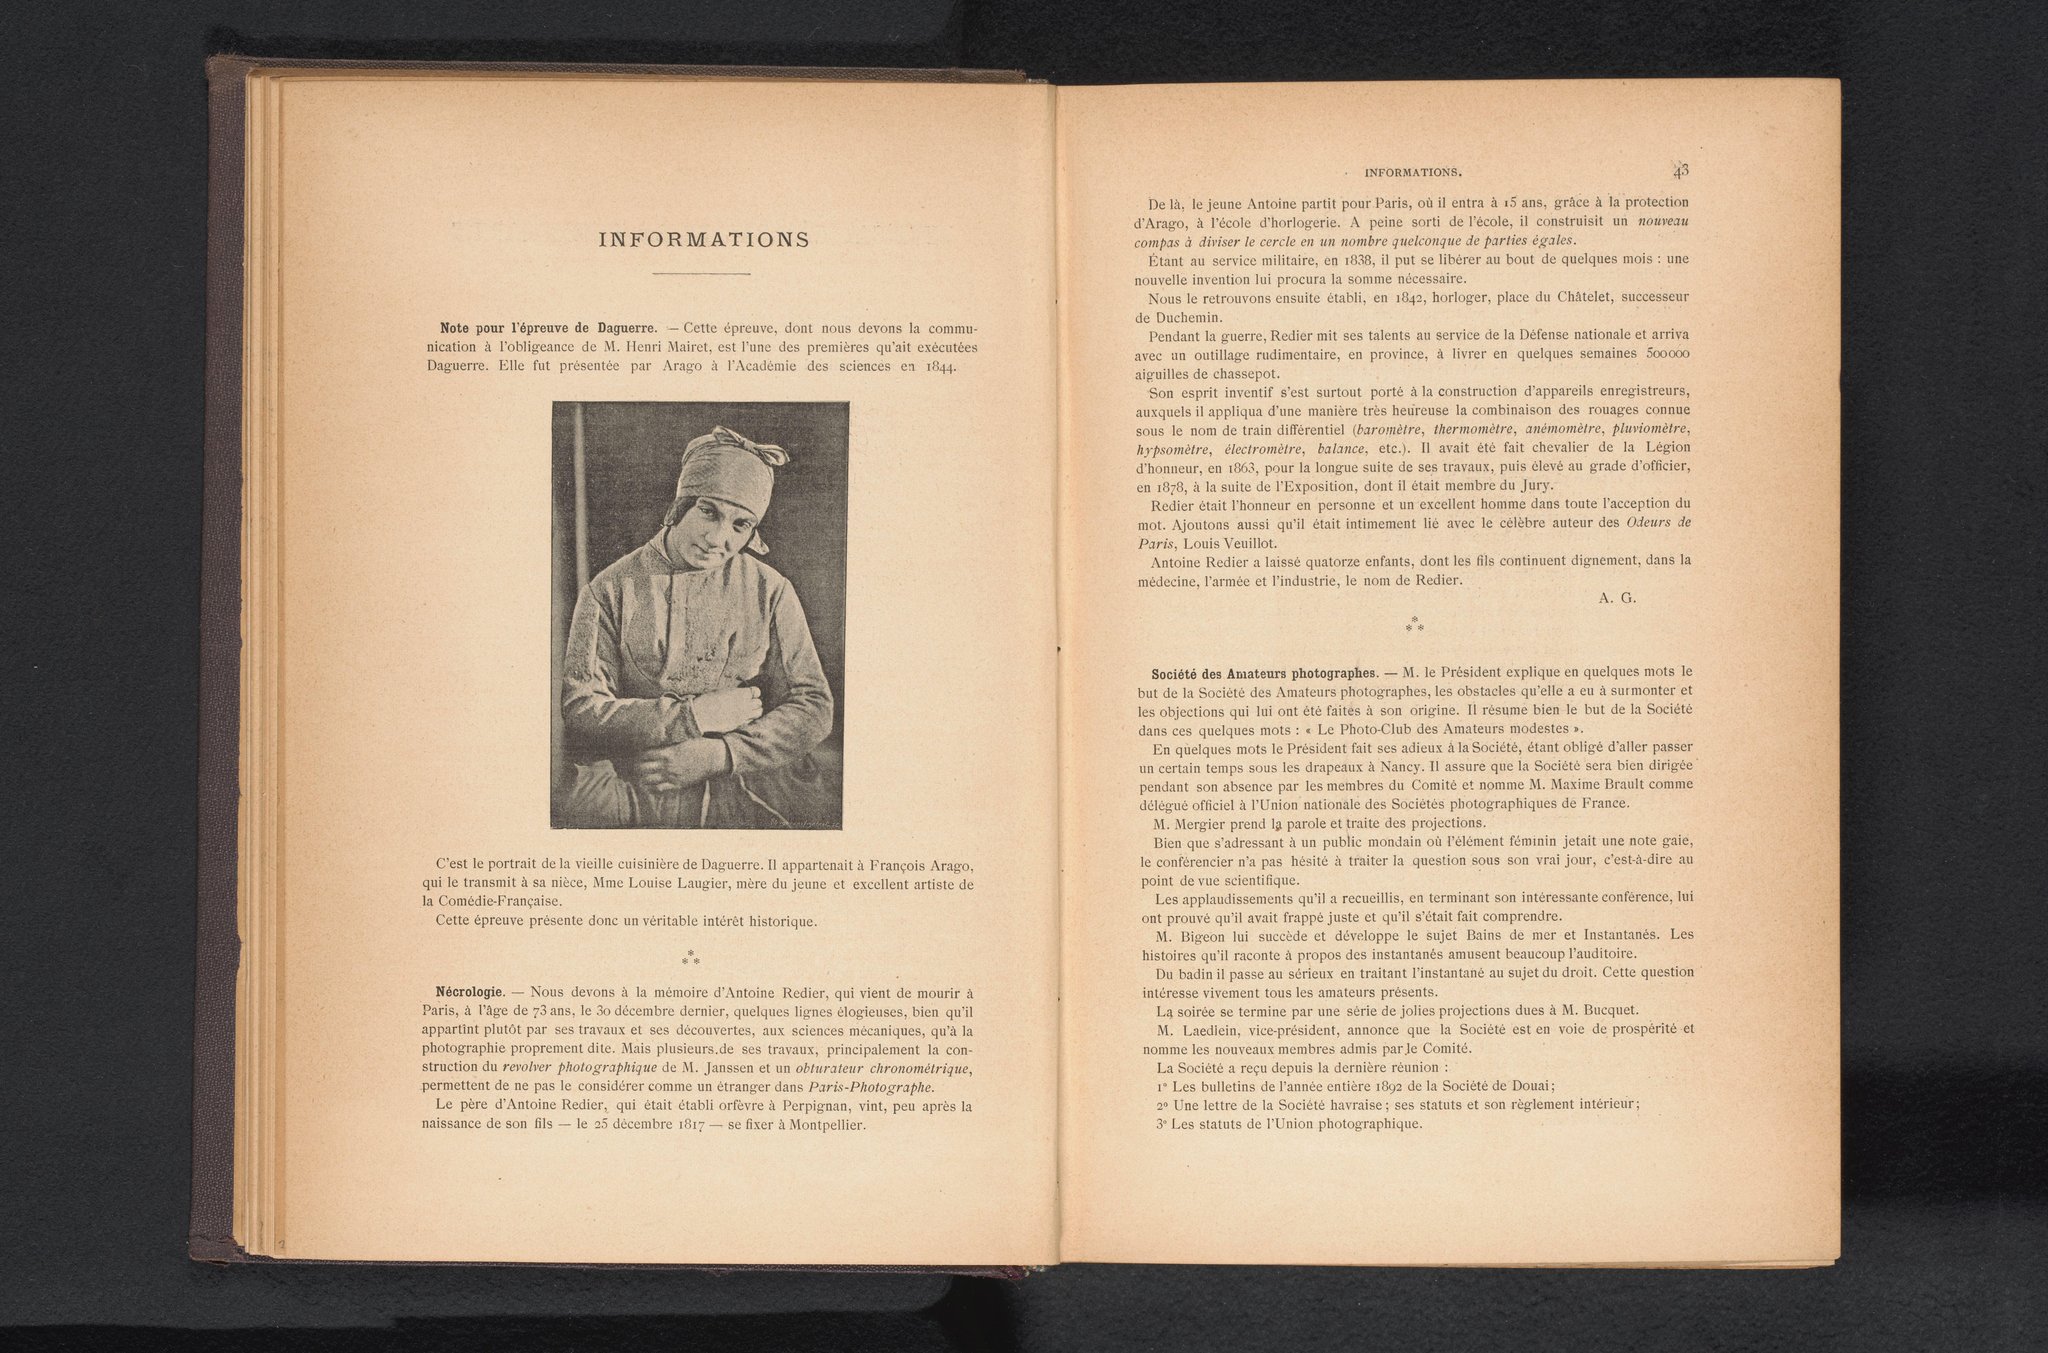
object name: page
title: Portret van vermoedelijk de kok van Louis Daguerre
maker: louis jacques mandé daguerre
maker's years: 1787-1851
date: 1883-1893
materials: paper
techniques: autotype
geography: france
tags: cook - cc - female cook